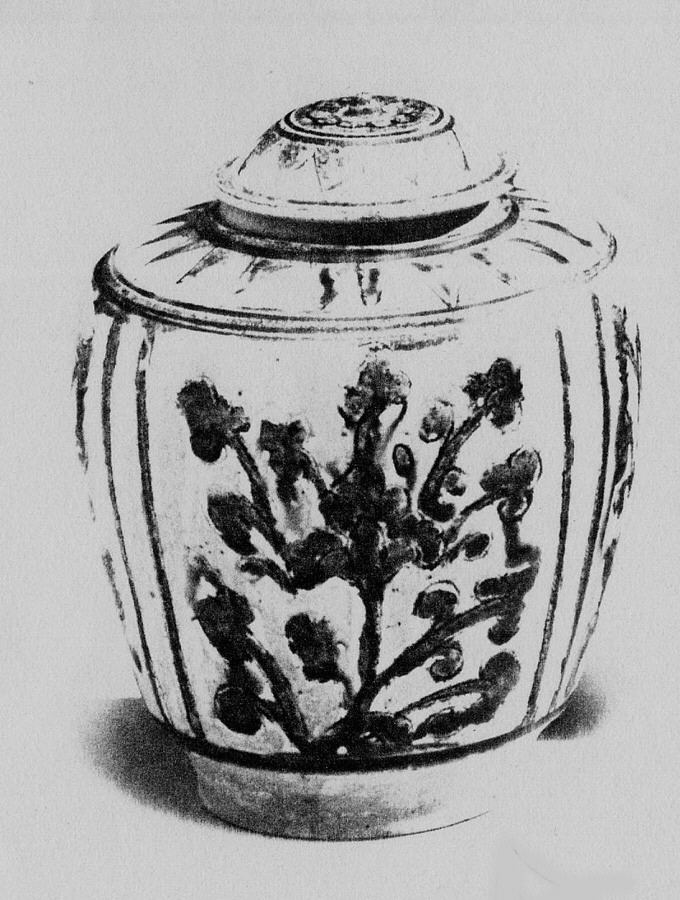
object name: covered jar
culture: thai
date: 1301-1500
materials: earthenware, glaze, iron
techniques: underglaze